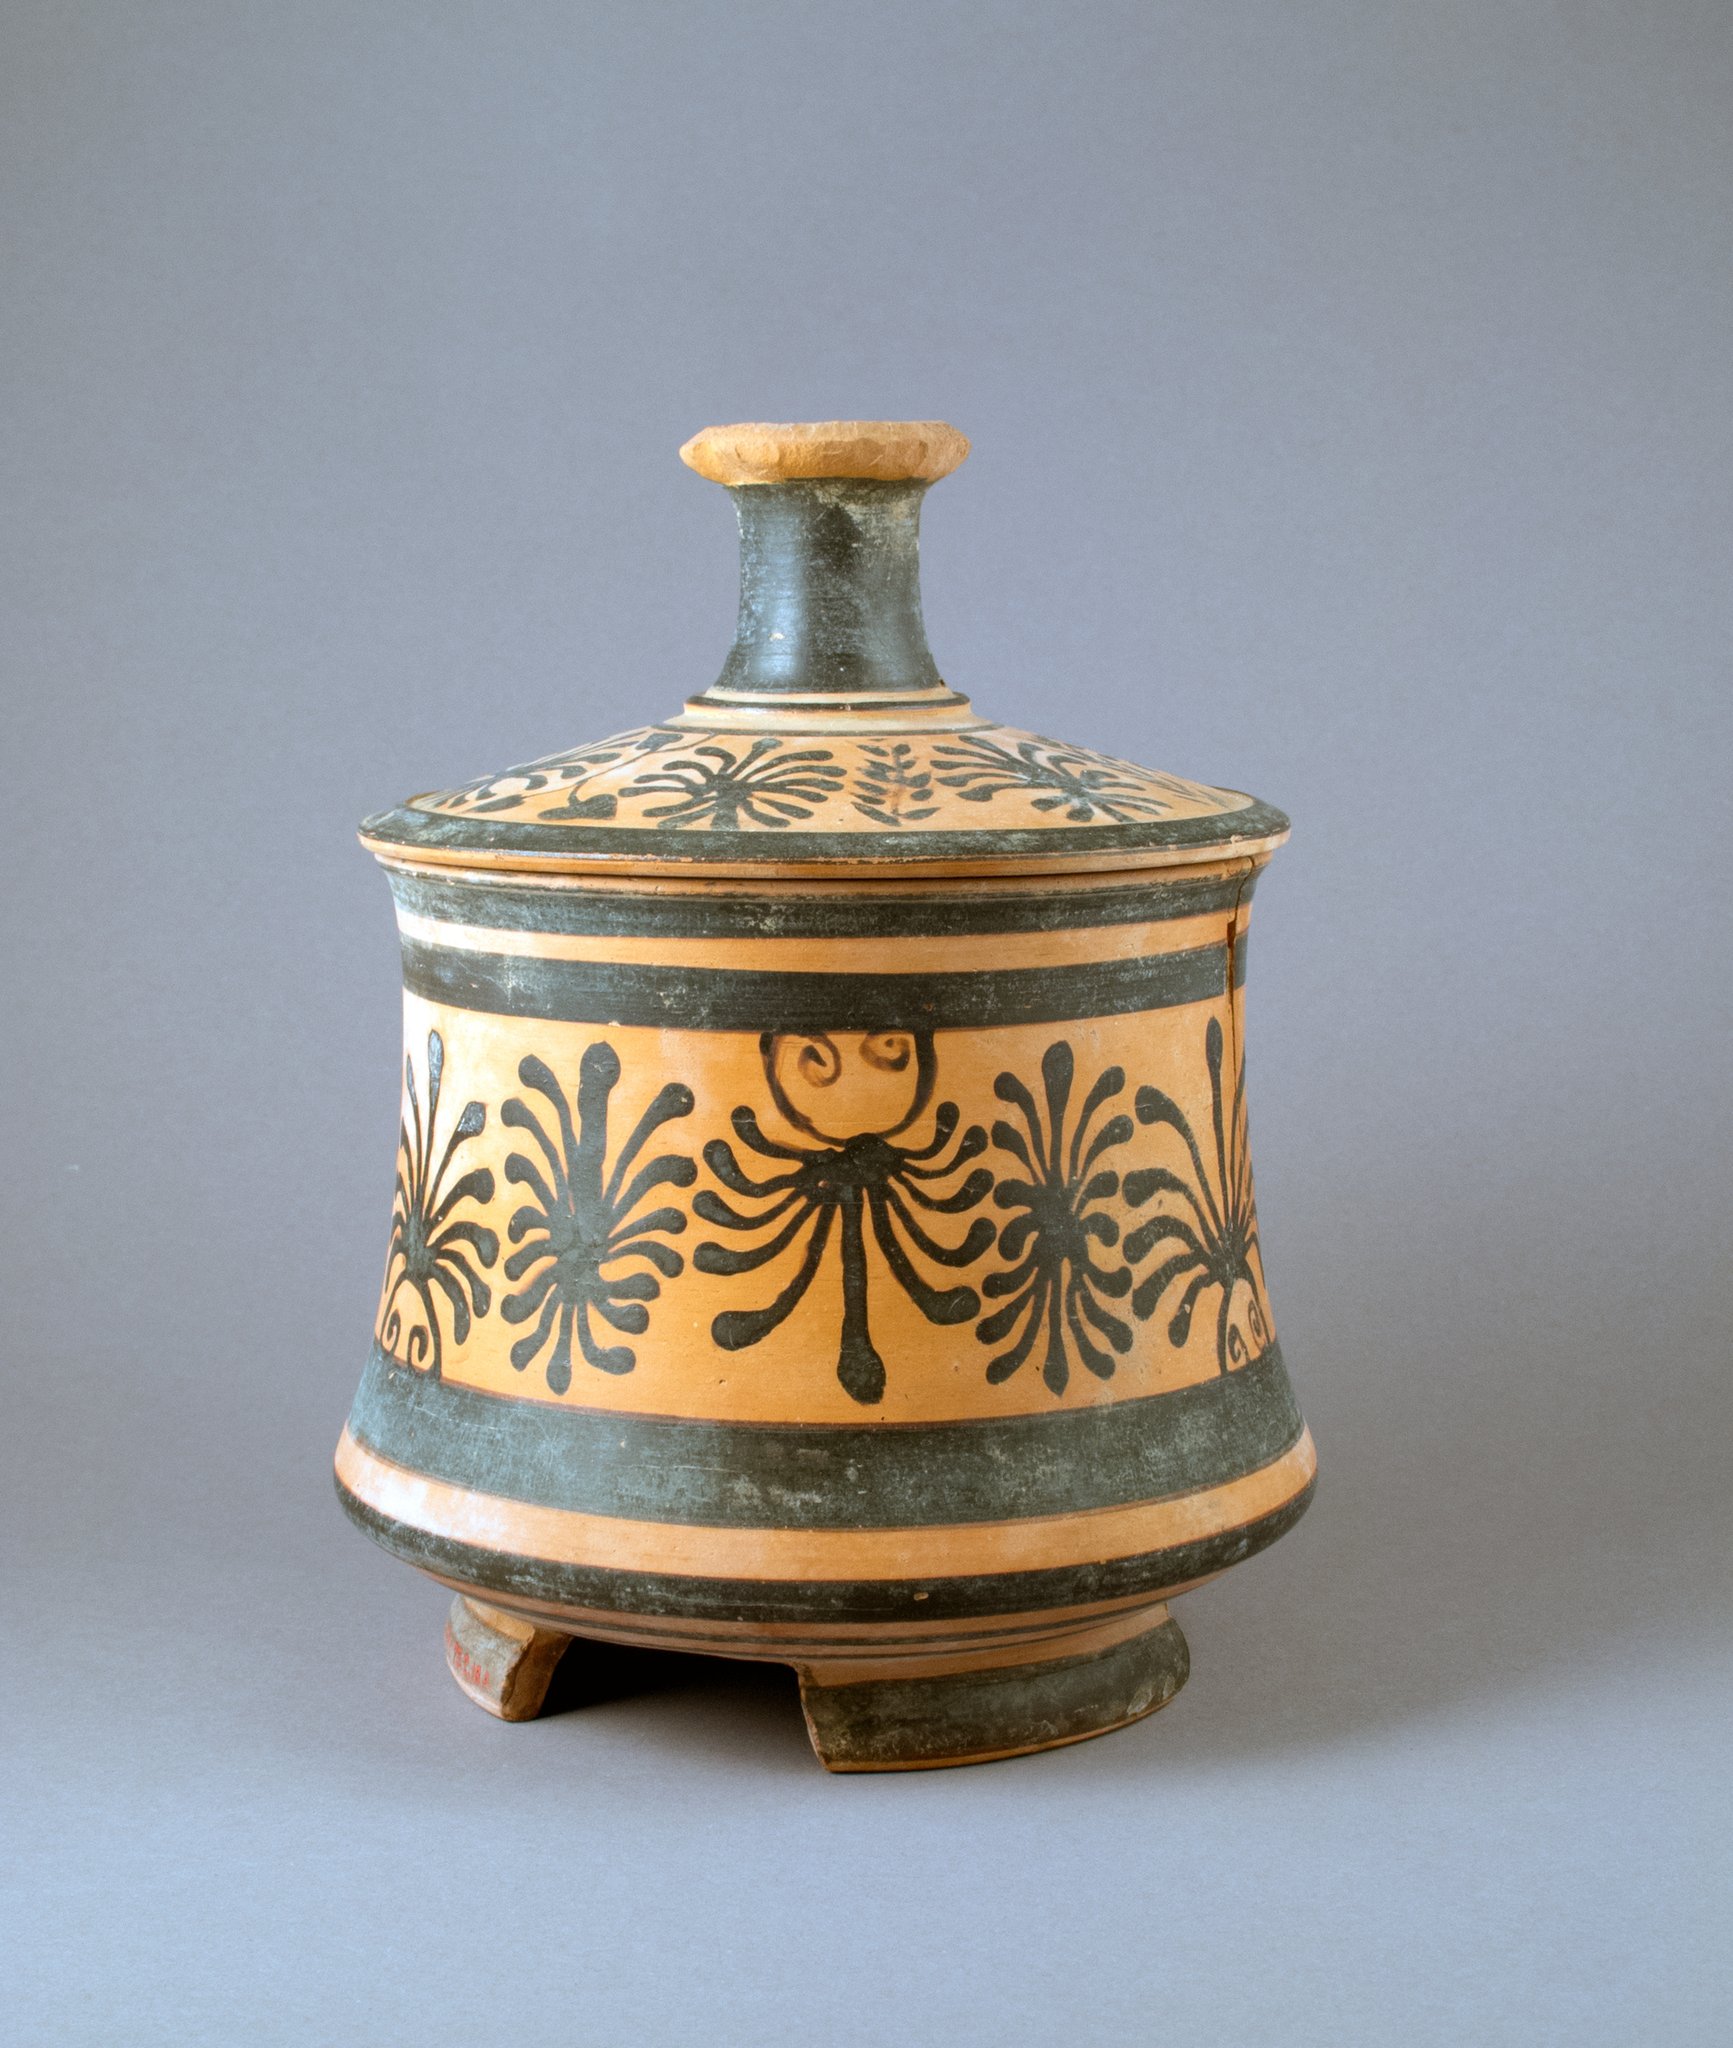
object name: pyxis with lid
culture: greek, boeotian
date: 434-401 BCE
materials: terracotta